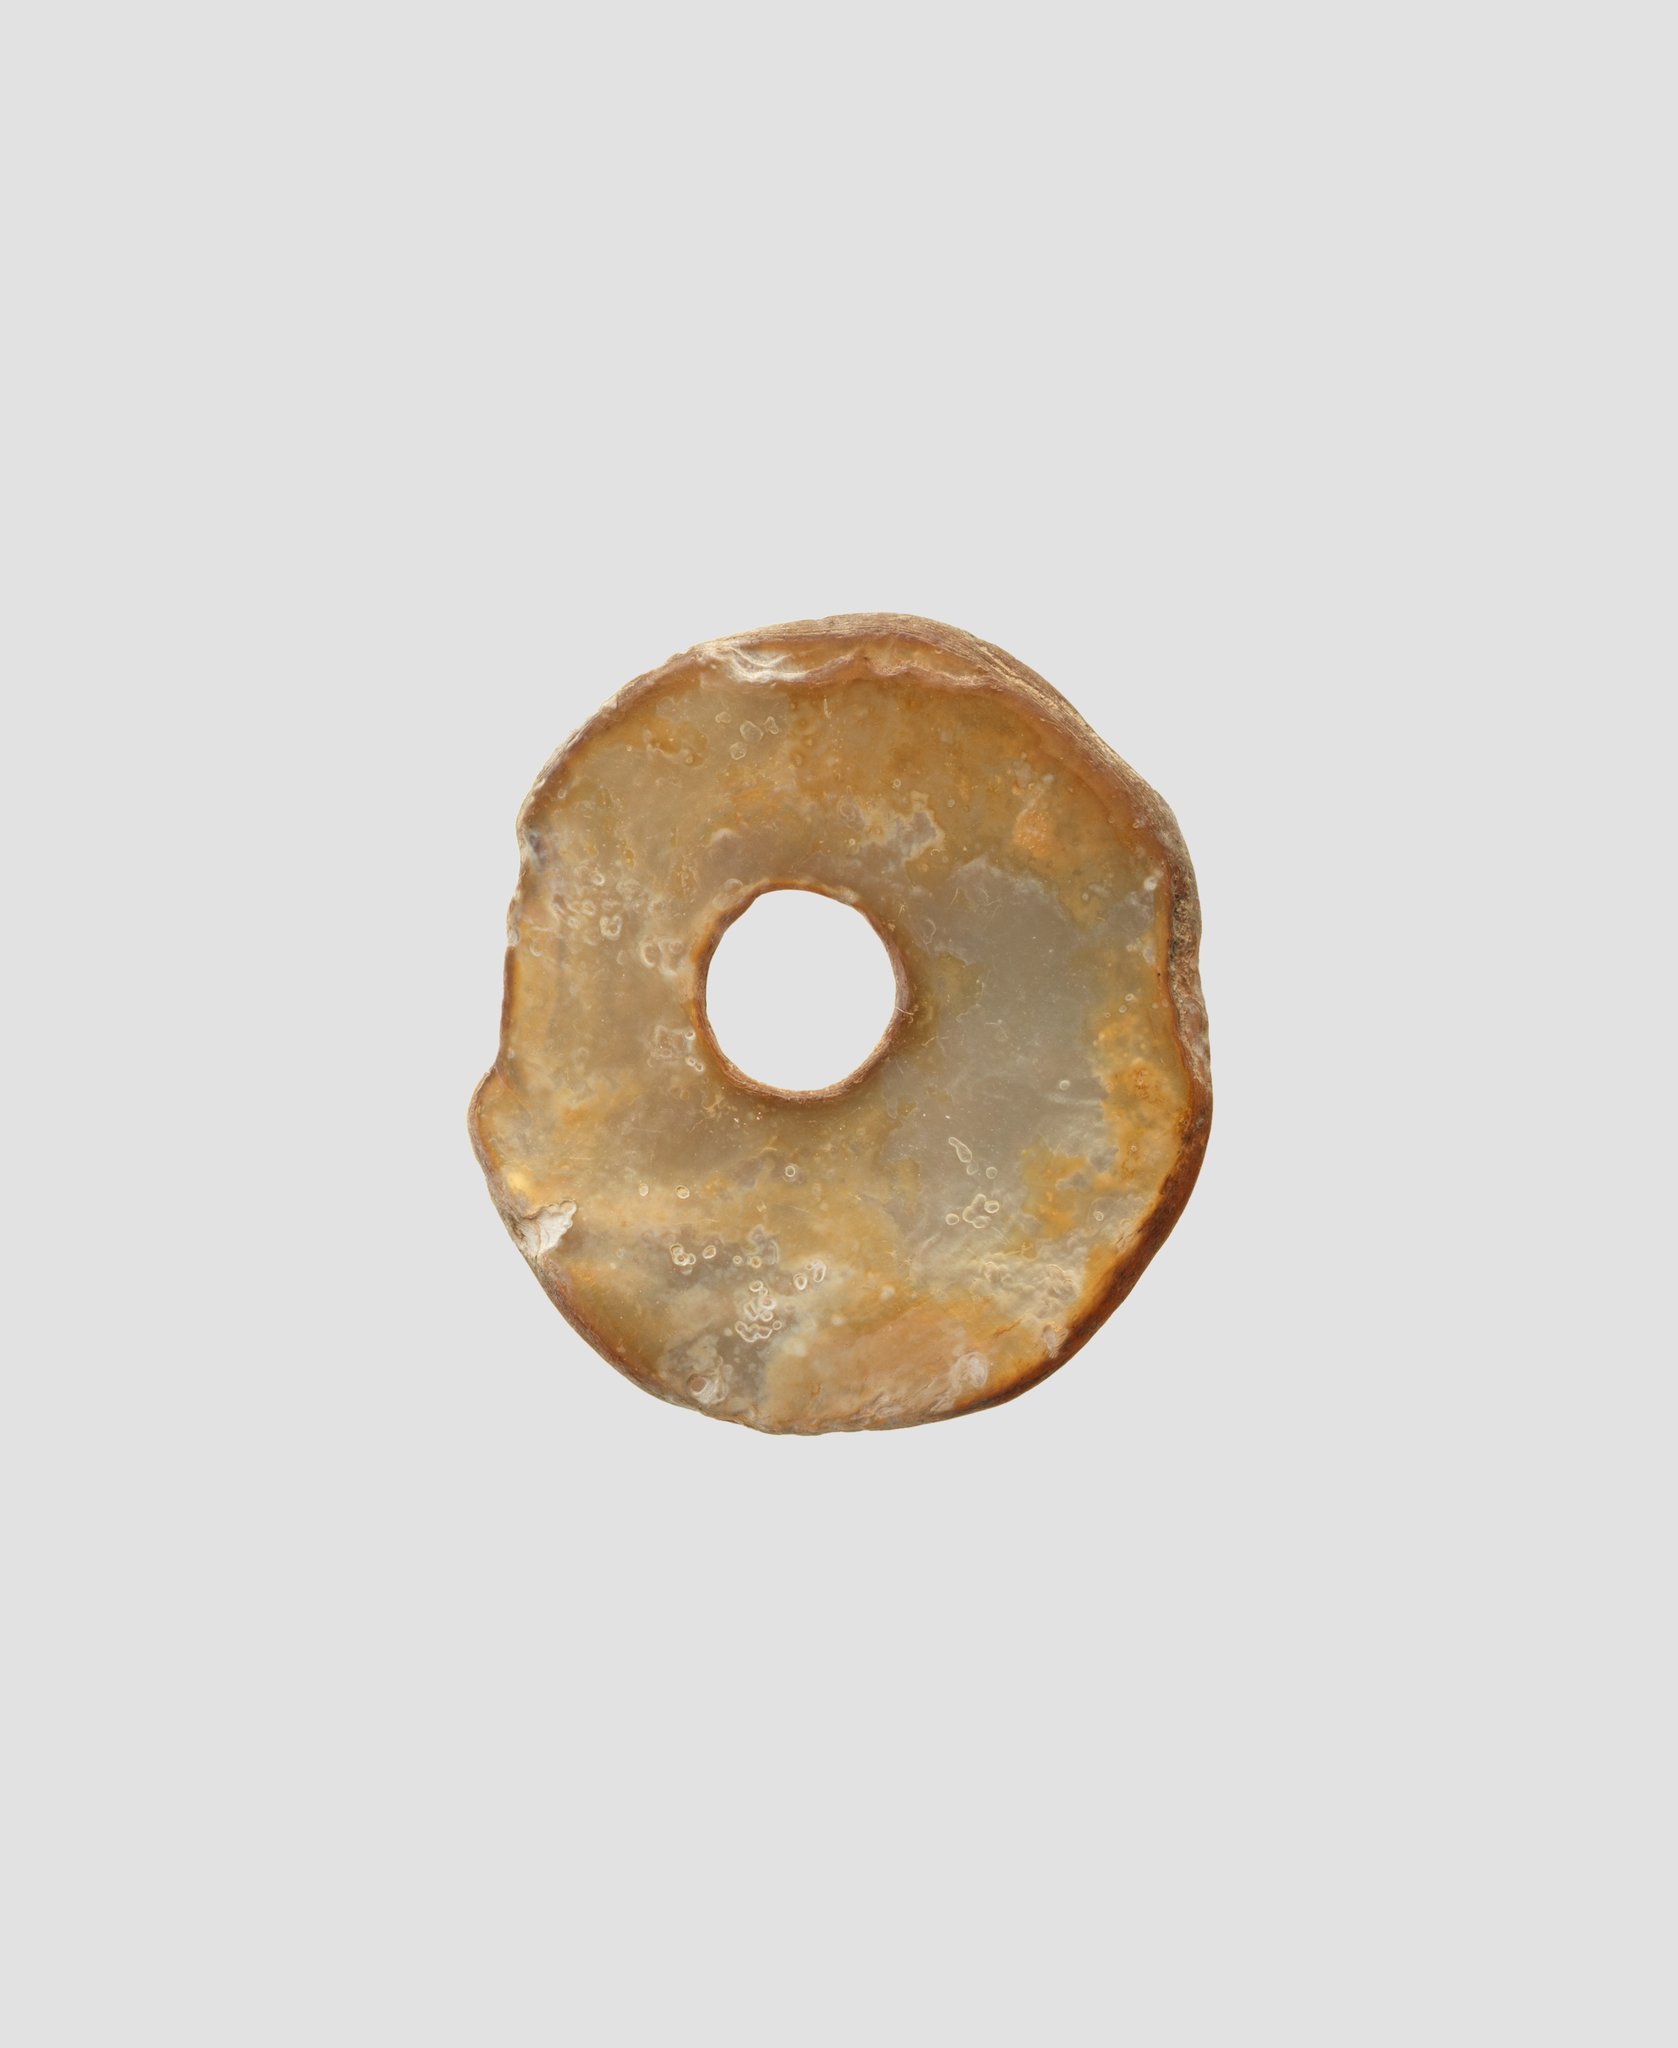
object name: ornament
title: Mother-of-pearl shell adornment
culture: alanic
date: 601-900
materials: shell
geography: caucasus